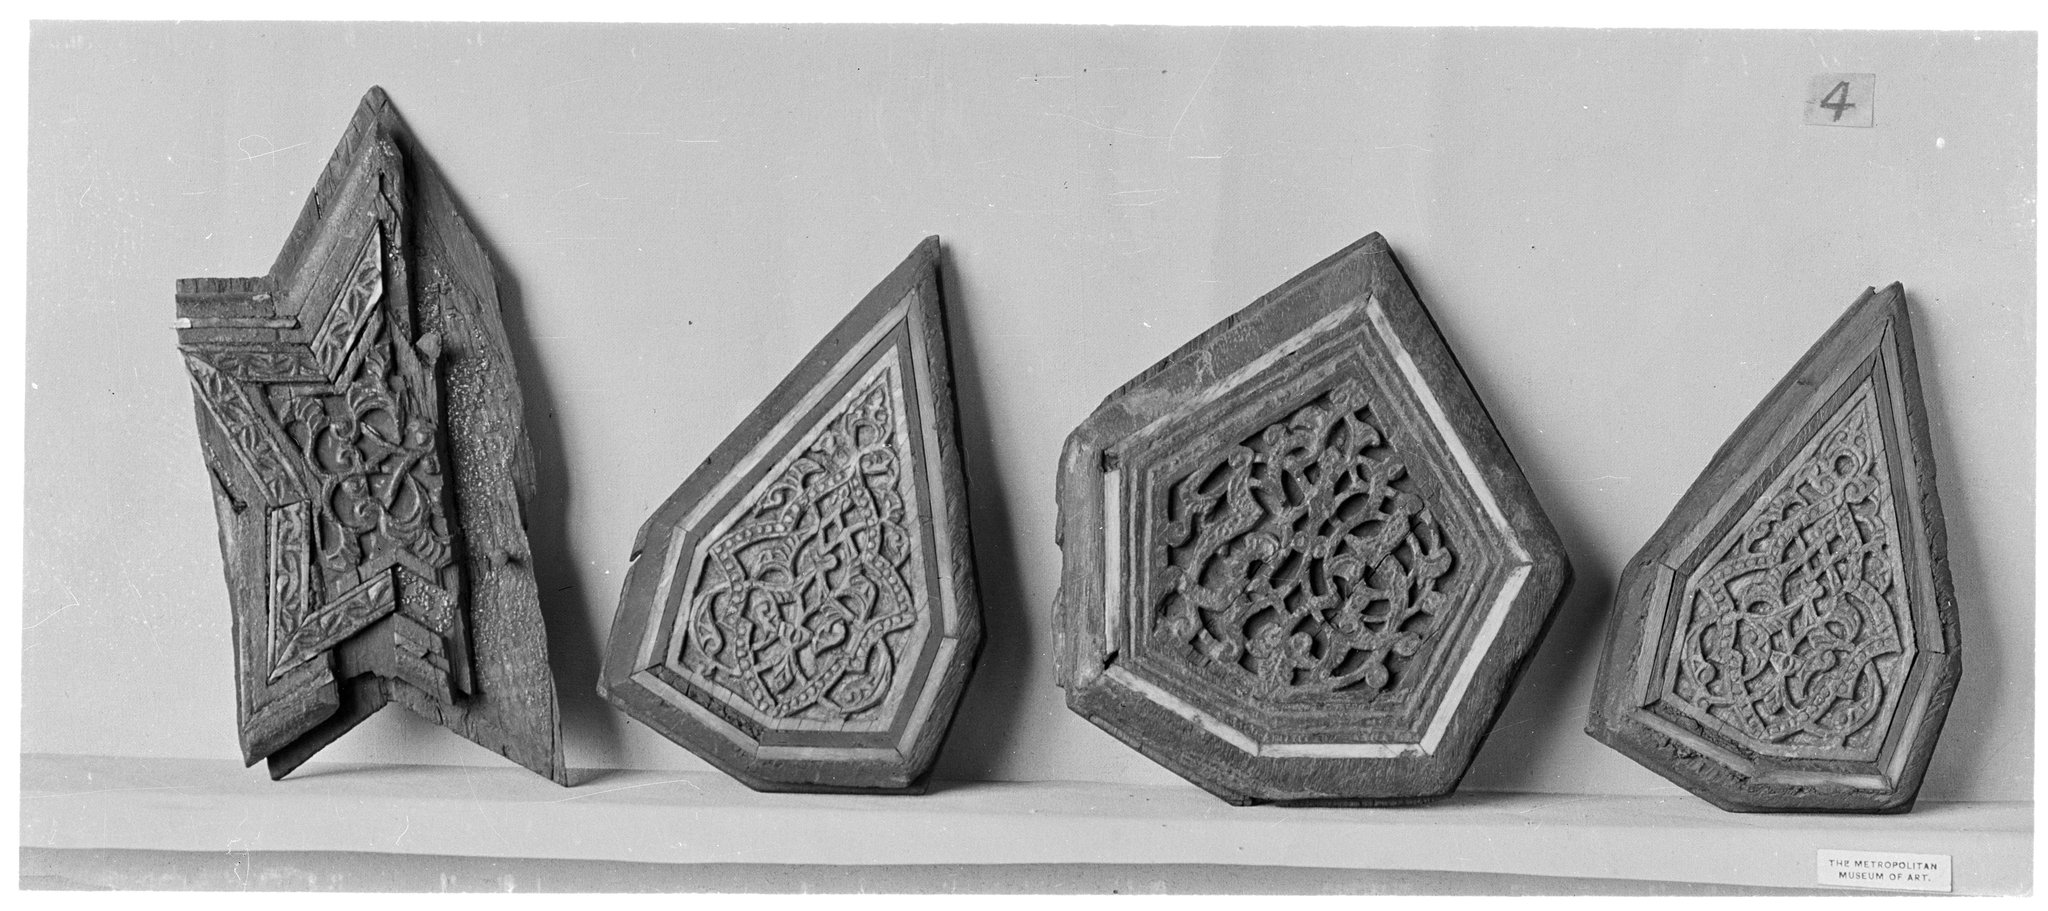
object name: panel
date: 1201-1300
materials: ivory, wood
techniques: carving, inlay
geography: egypt